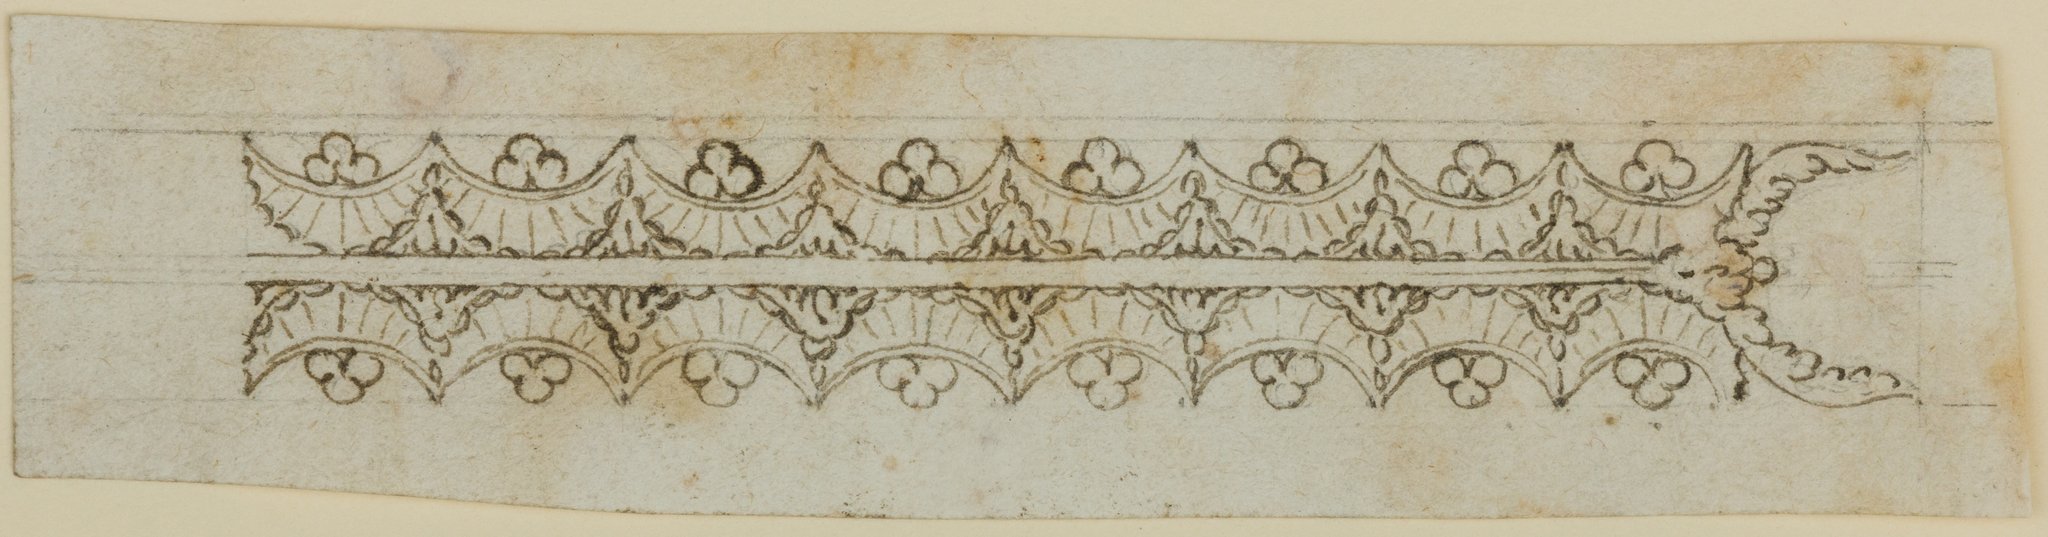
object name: drawing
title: Designs for the Decoration of Firearms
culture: french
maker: nicolas noël boutet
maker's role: designer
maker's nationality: french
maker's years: 1761-1833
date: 1797-1805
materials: ink, paper, pencil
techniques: wash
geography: france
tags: ornament